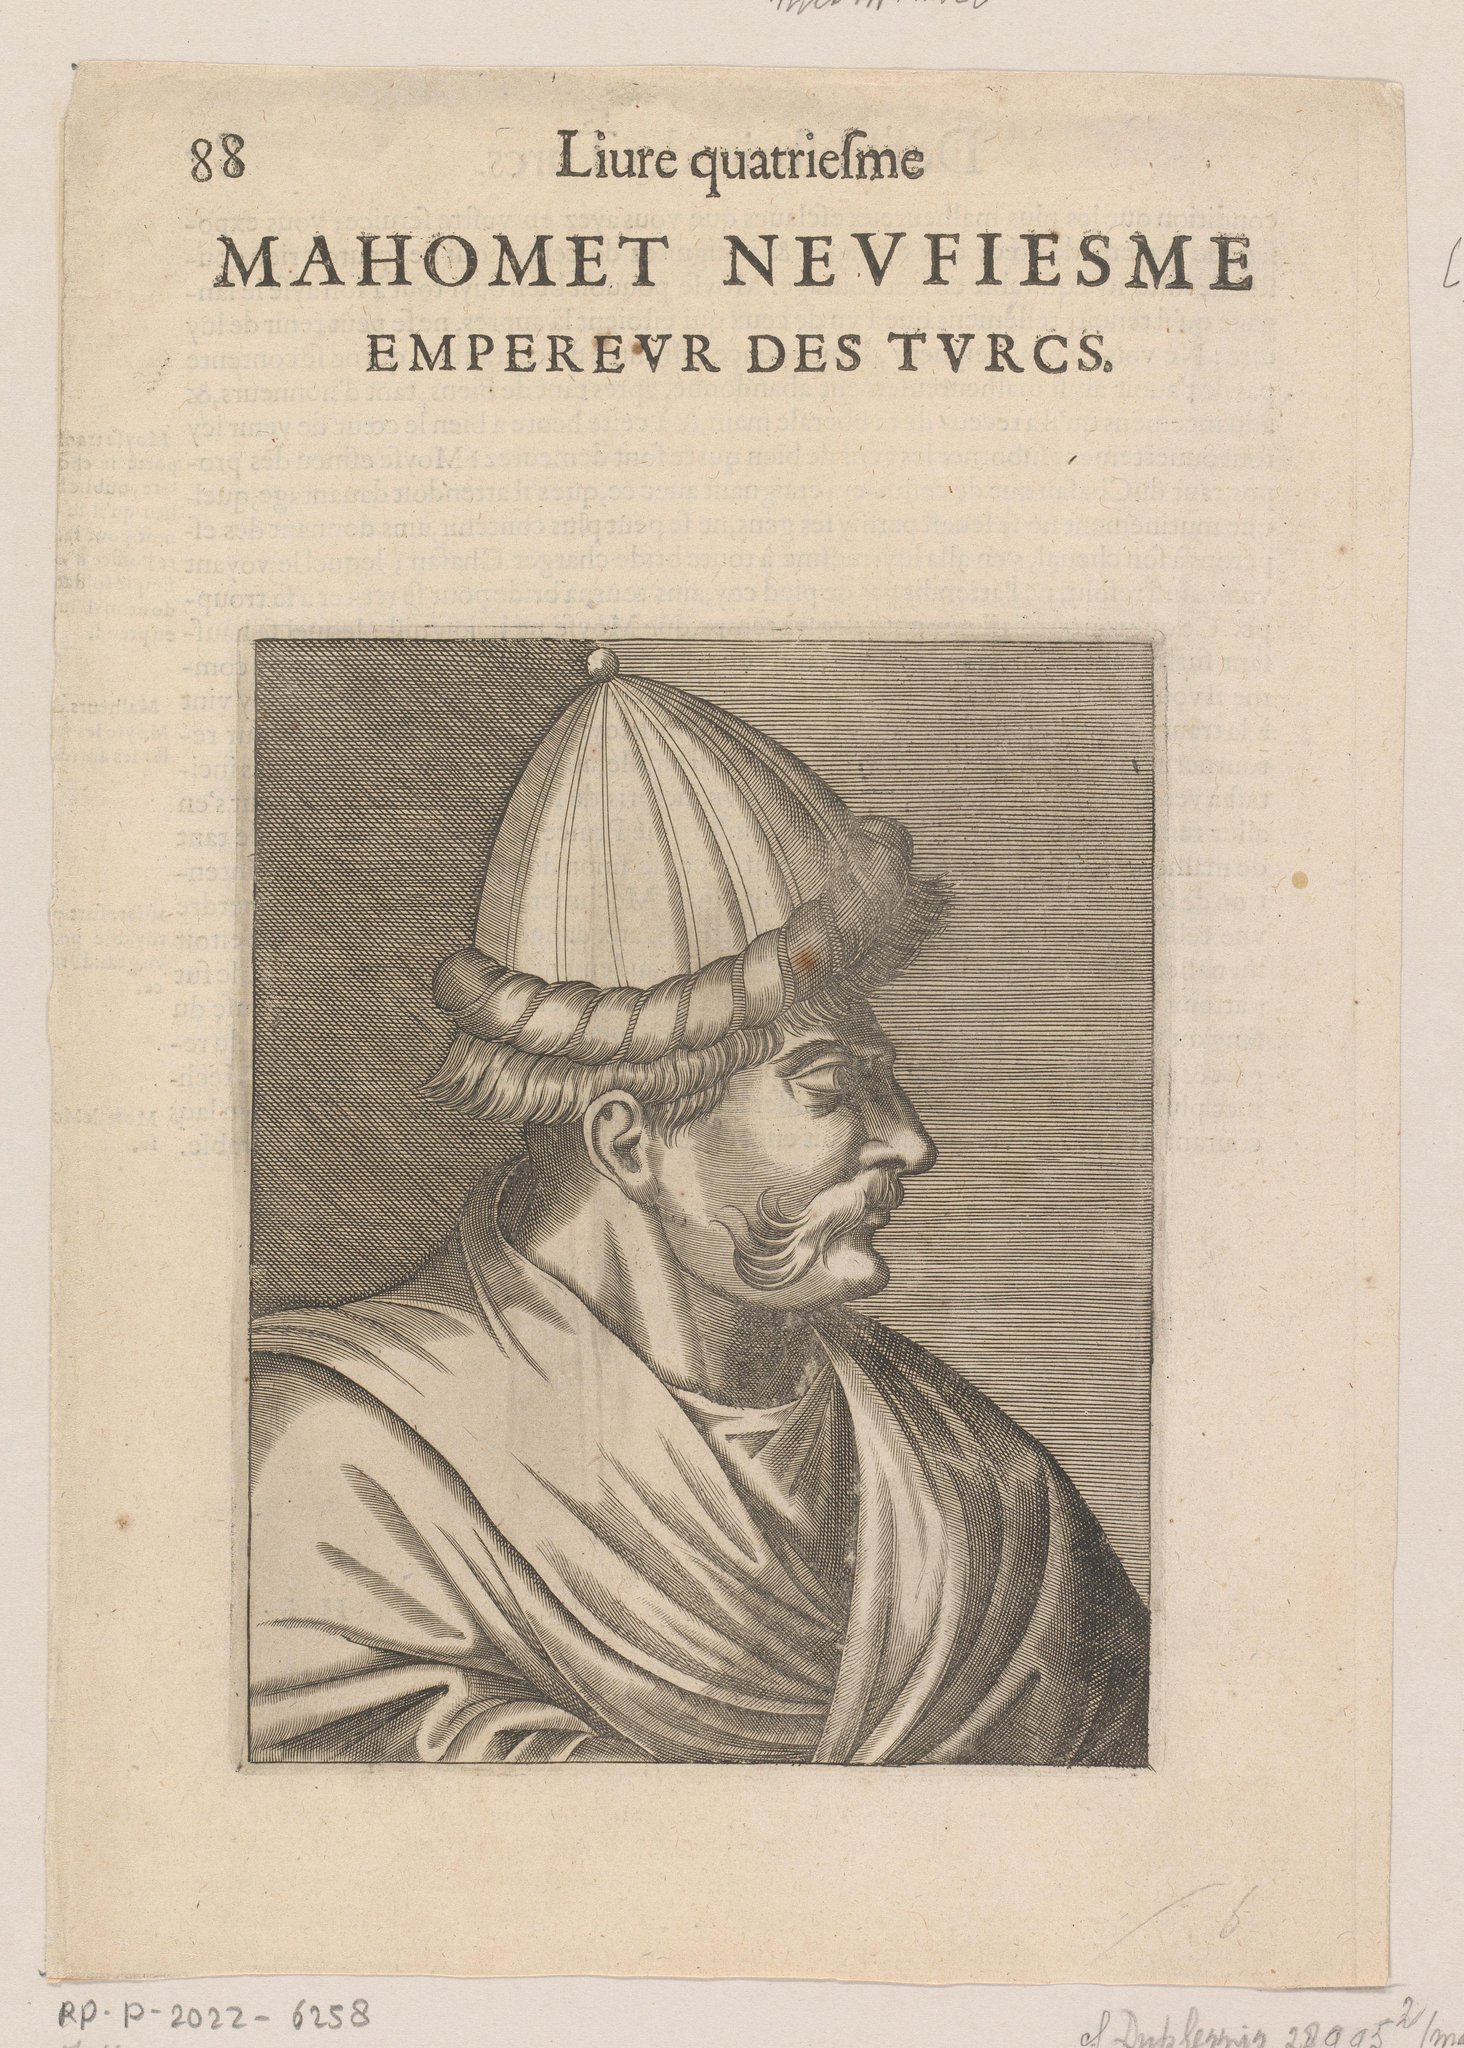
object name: print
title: Portret van Mehmet I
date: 1632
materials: paper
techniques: engraving, letterpress printing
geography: paris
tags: politician, historical persons, ruler, sovereign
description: Prent uit: Chalkokonylou, Laonikou. L'histoire de la decadence de l'Empire Grec, et establissement de celuy des Turcs, (...). Parijs: Claude Sonnius, 1632.